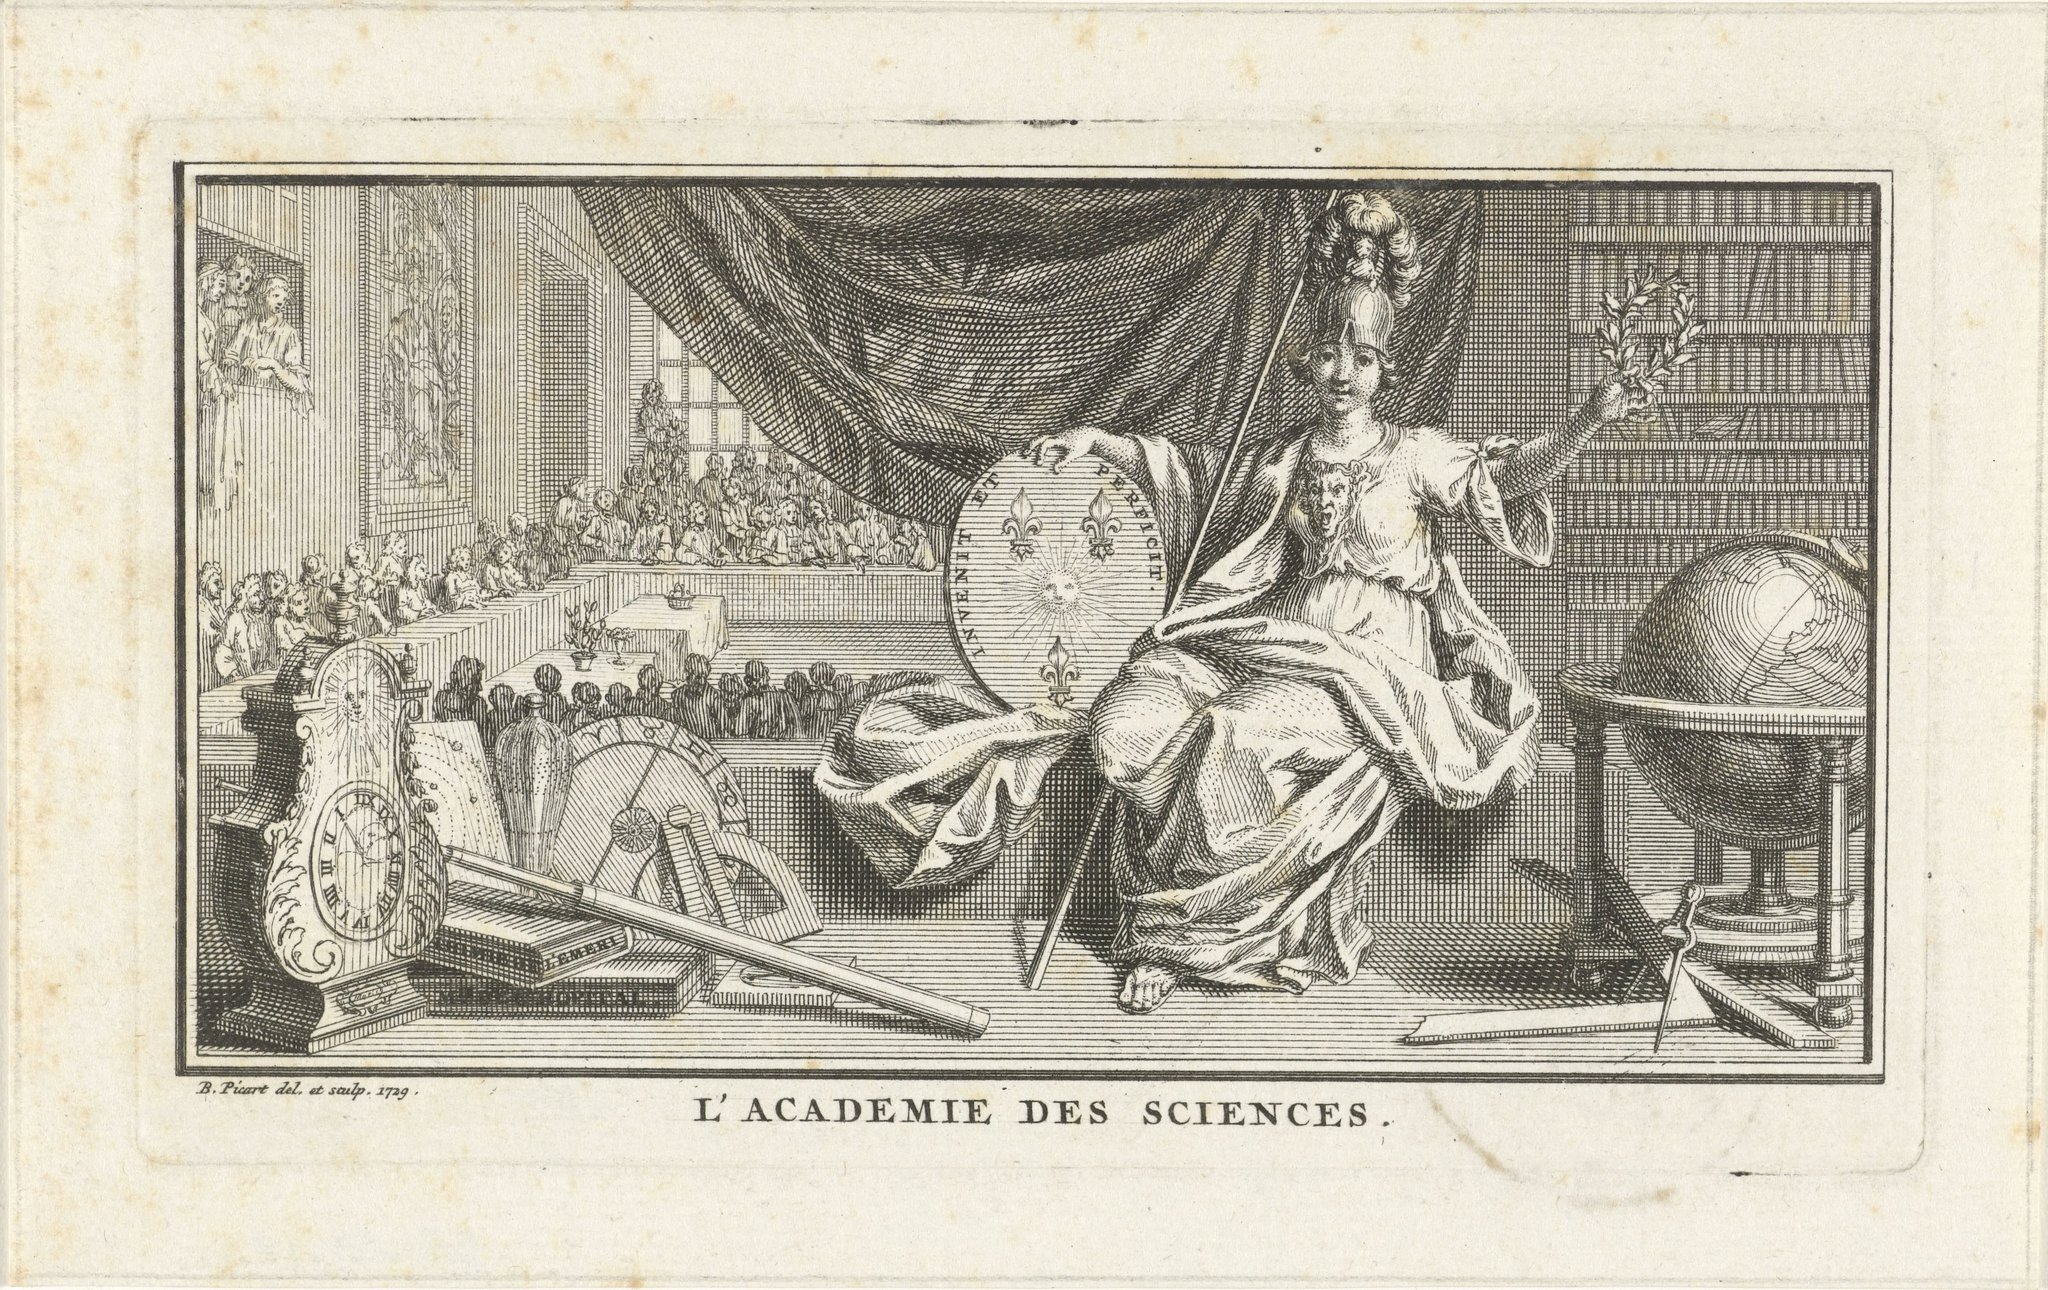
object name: print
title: Allegorie op wetenschappen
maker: bernard picart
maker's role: draughtsman, print maker, publisher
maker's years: 1673-1733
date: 1729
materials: paper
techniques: engraving, etching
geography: amsterdam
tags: university building, college (+ lesson, lecture), personification of university; 'academia' (ripa), (story of) minerva (pallas, athena)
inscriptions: collector's mark: Lugt 240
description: Minerva, godin van de wijsheid, met het Franse wapenschild en een lauwerkrans in de handen. Links op de achtergrond een collegezaal van de Academie van Wetenschappen waar een lezing gehouden wordt.